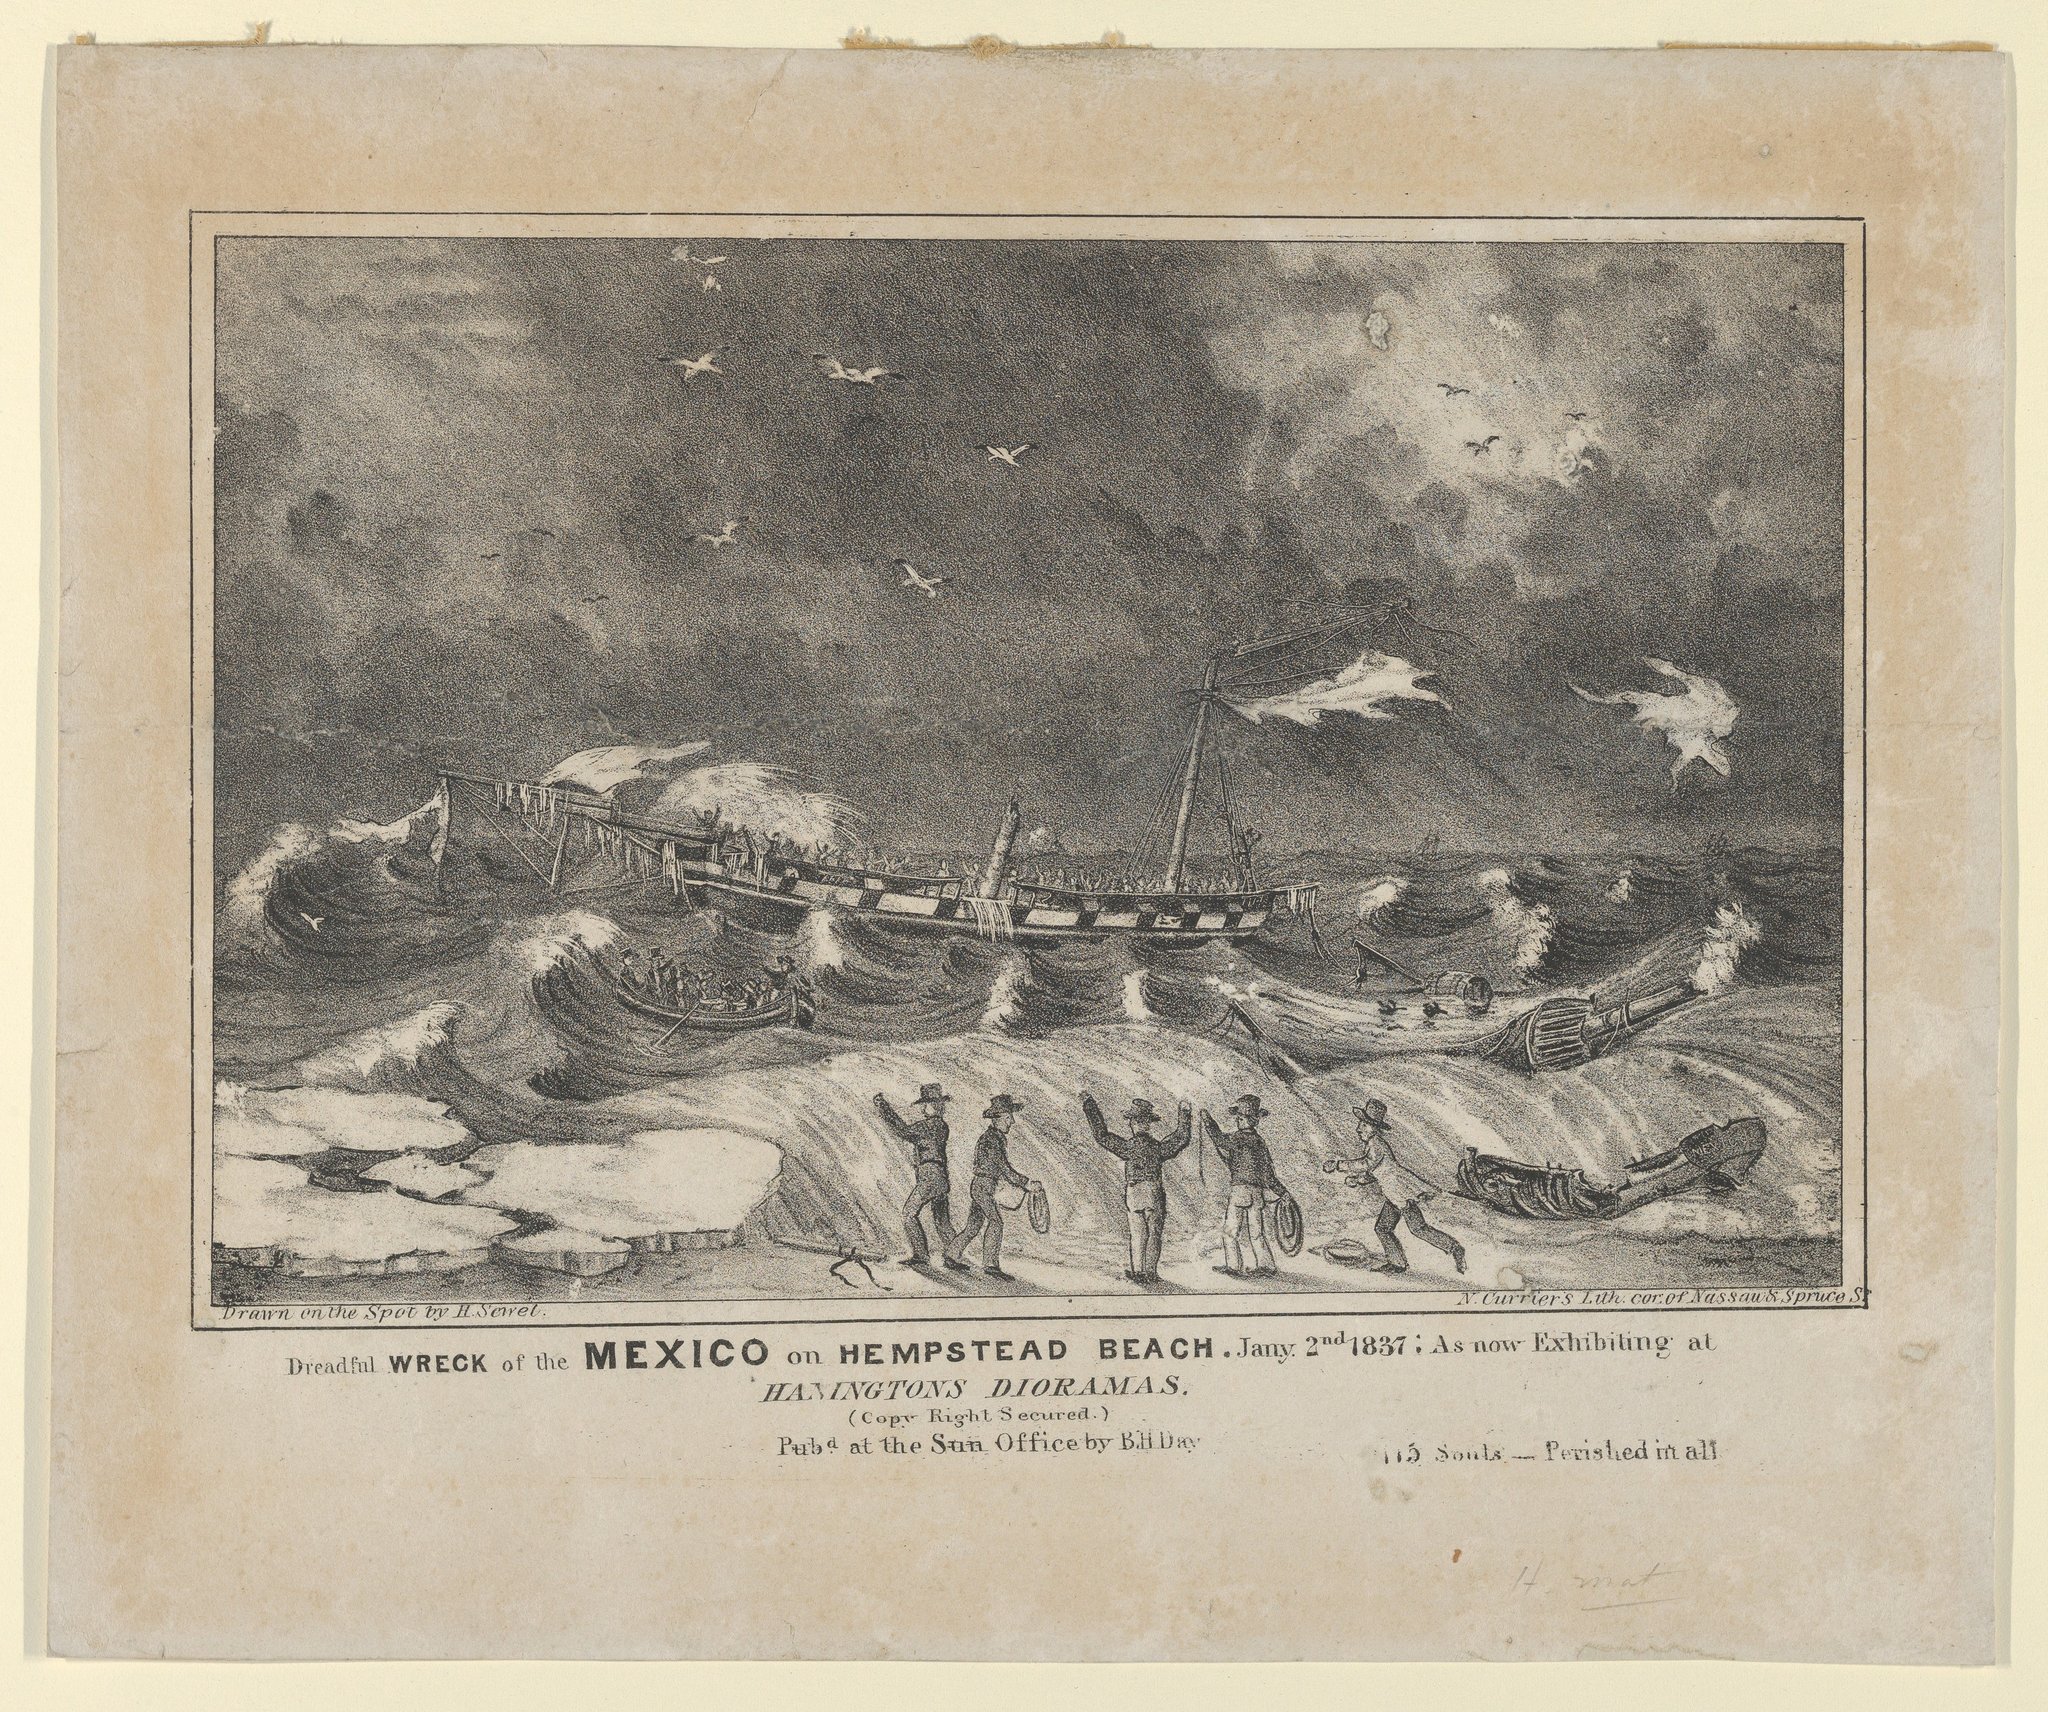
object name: print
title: Dreadful Wreck of the Mexico on Hempstead Beach, January 2nd, 1837 – As Now Exhibiting at Hanington Dioramas–Perished in All–115 Souls.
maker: h. sewell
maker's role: artist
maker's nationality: american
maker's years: 1836-1837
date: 1846-1856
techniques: hand coloring, lithograph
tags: men,oceans,waves,storms,ships